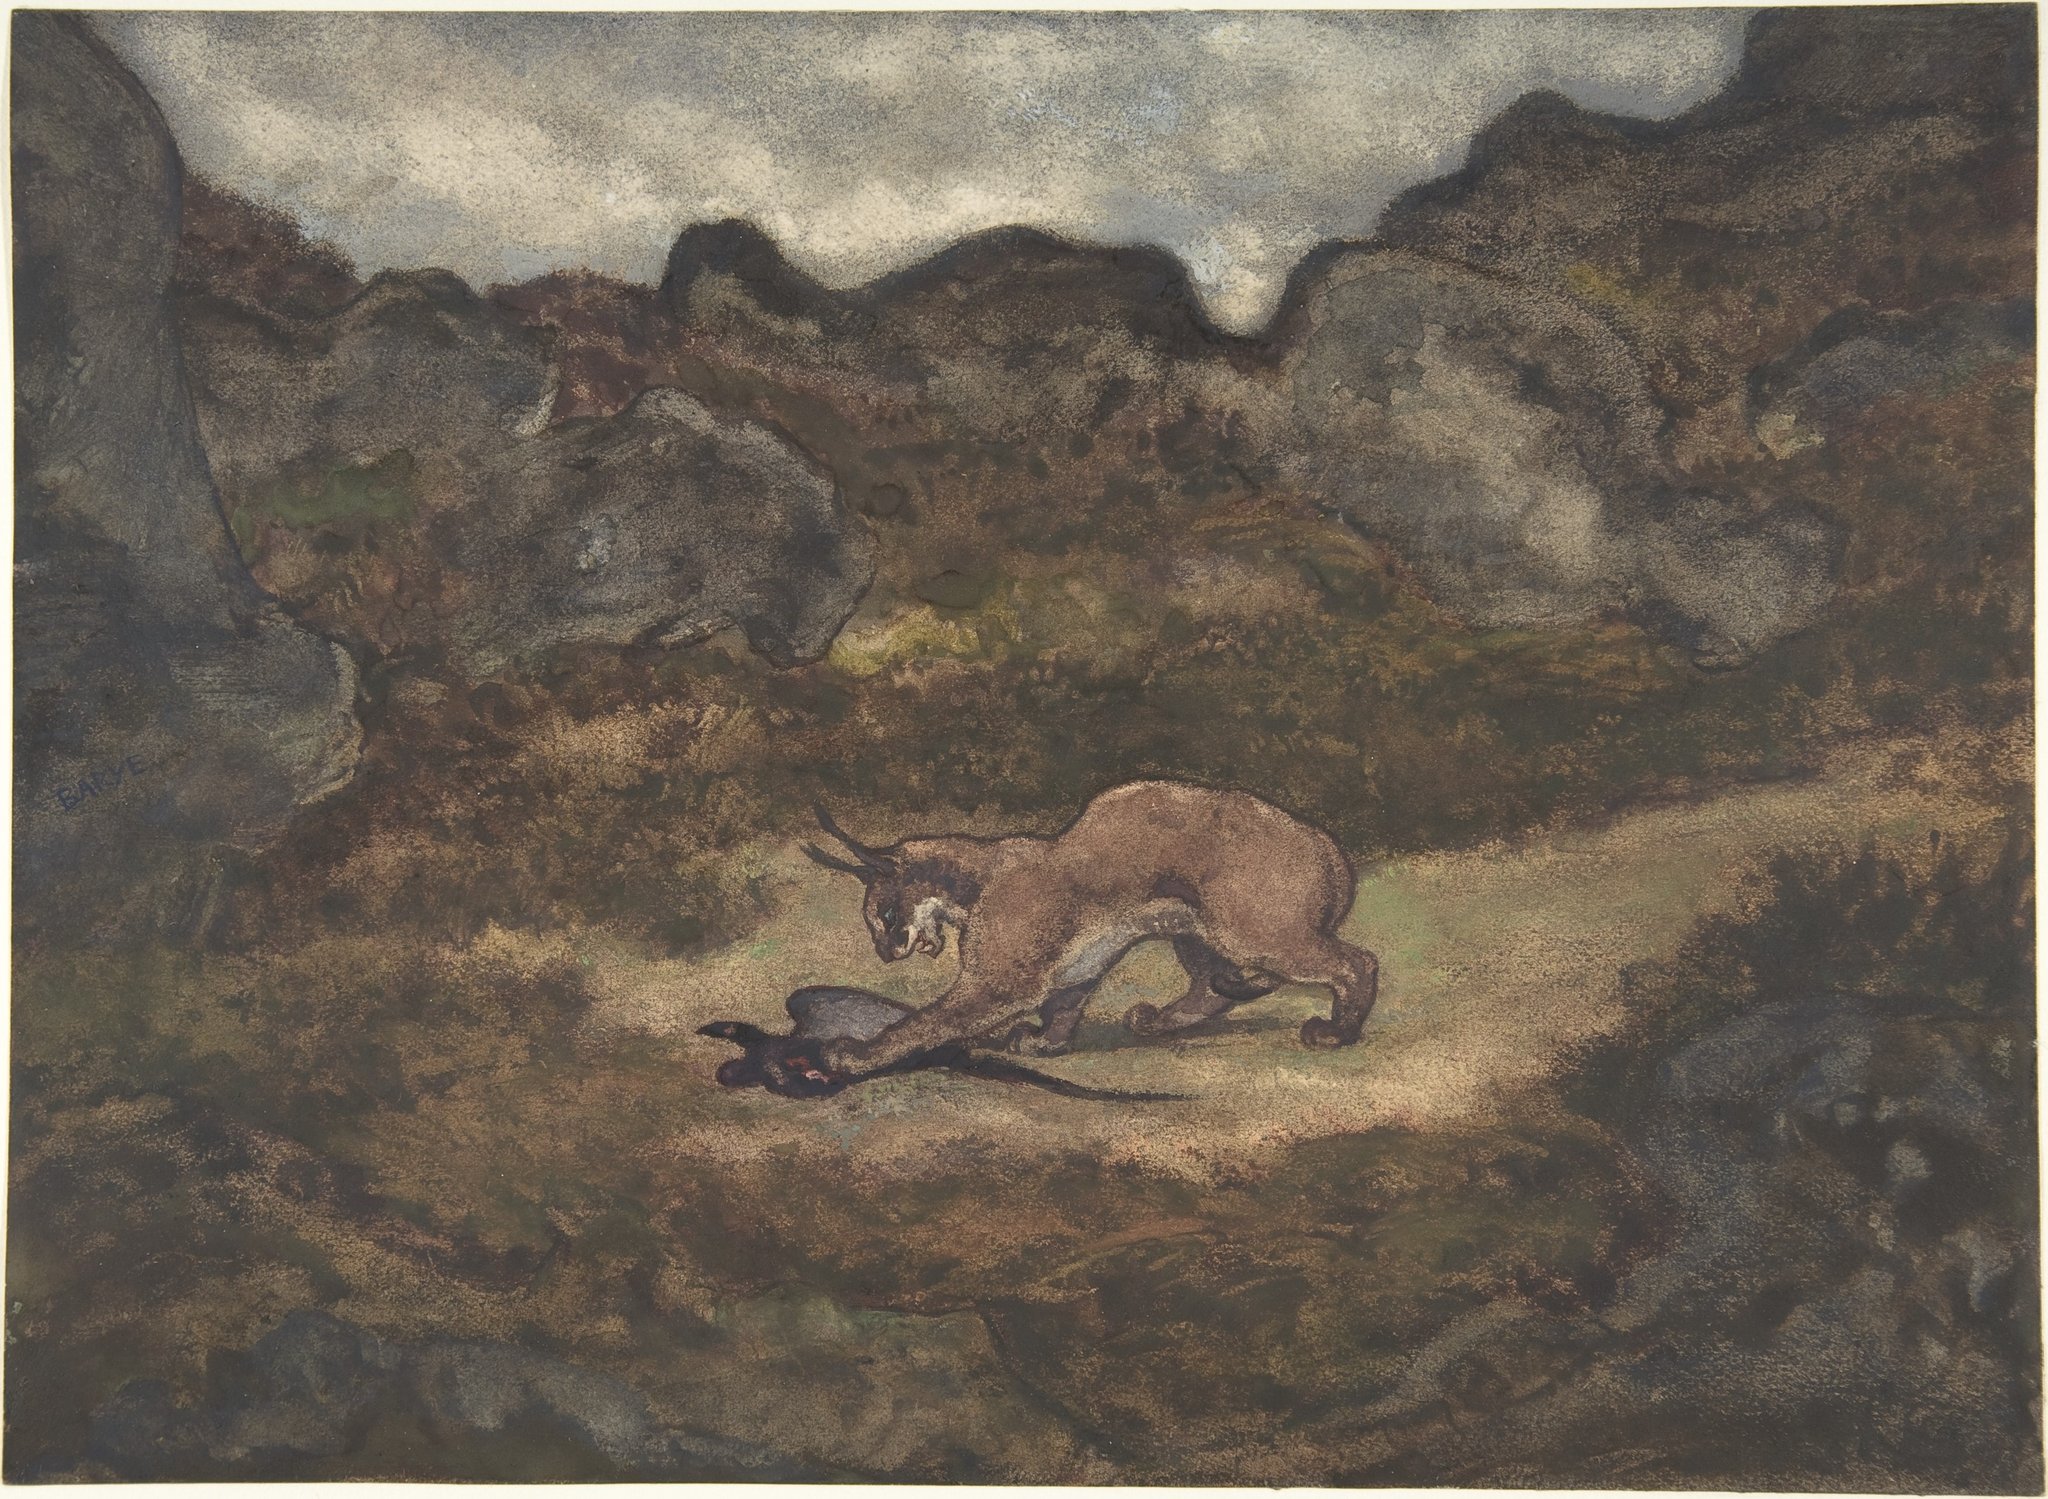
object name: drawing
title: Caracal and Pheasant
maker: antoine-louis barye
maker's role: artist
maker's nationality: french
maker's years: 1795-1875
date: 1810-1875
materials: watercolor, paper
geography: france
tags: animals,pheasants